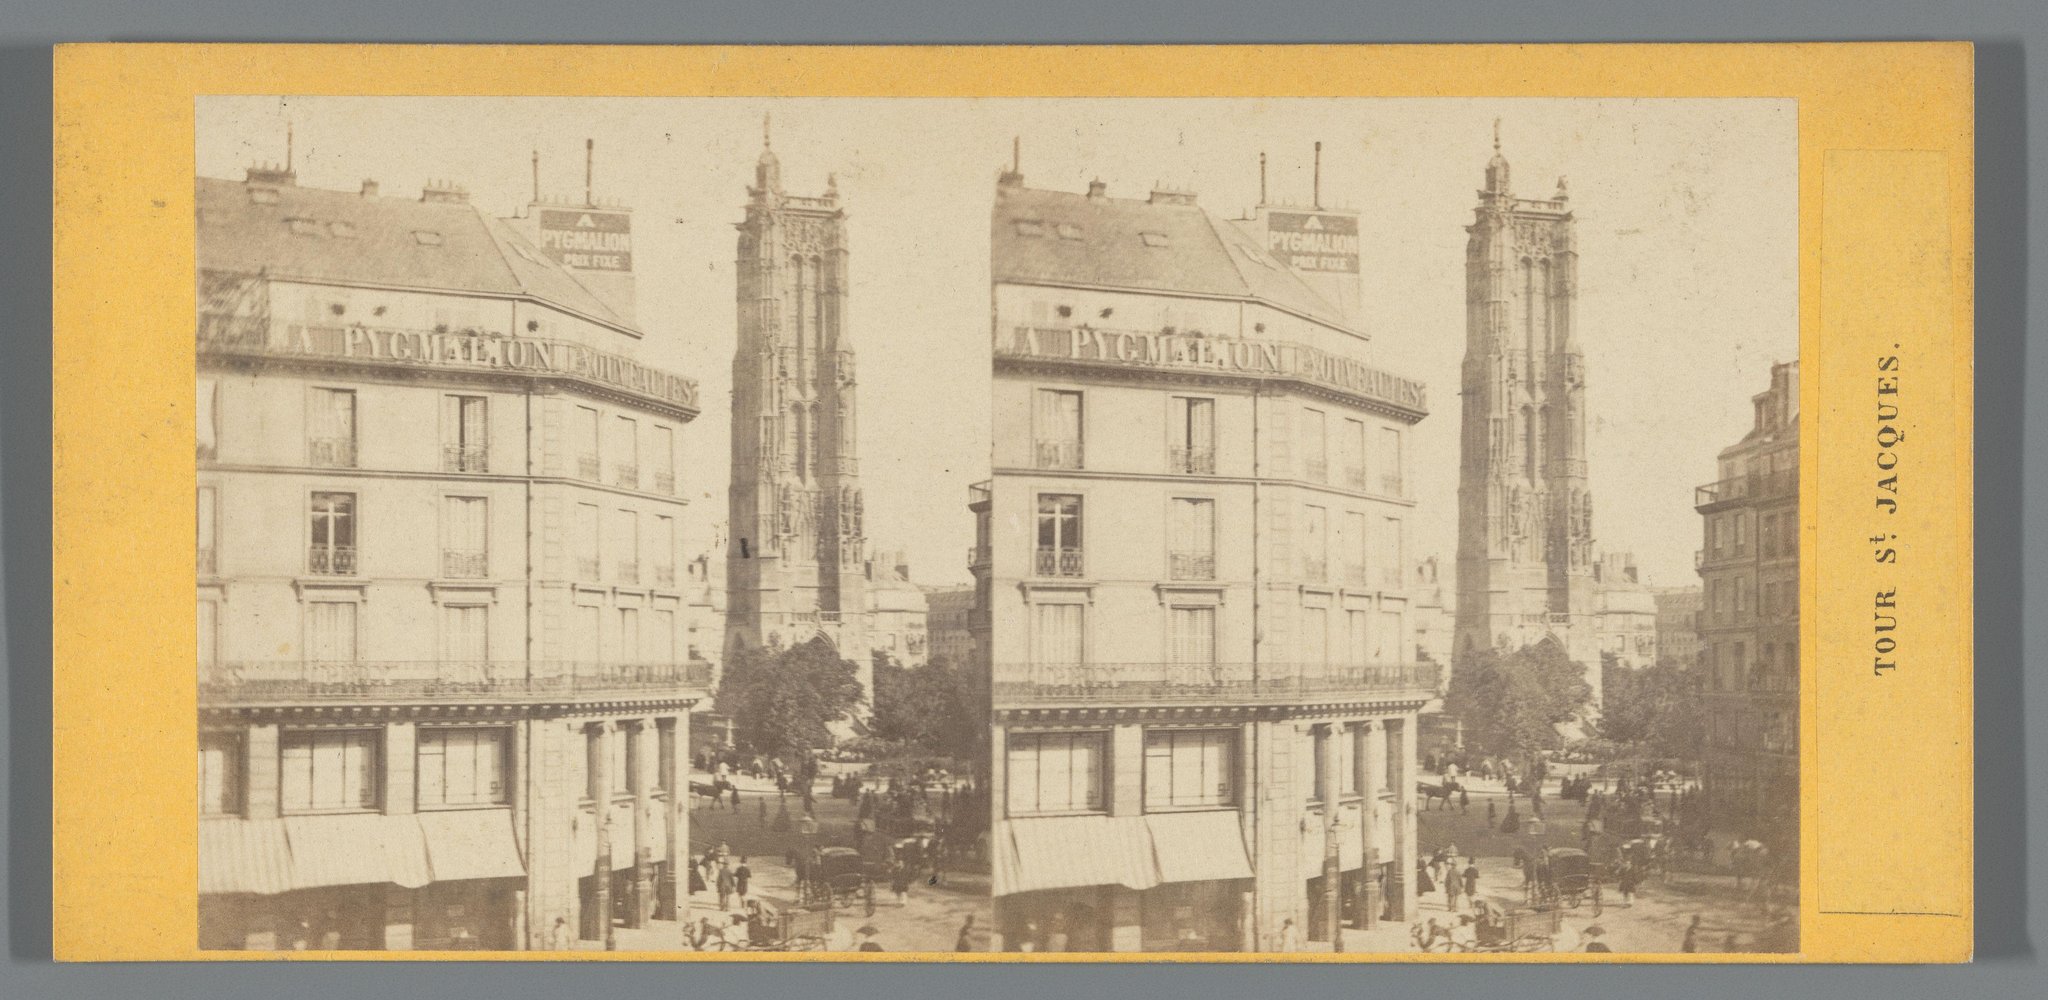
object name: stereograph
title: Tour St. Jacques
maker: Anonymous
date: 1861-1870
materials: cardboard, paper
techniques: albumen print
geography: paris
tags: parts of church exterior and annexes: tower